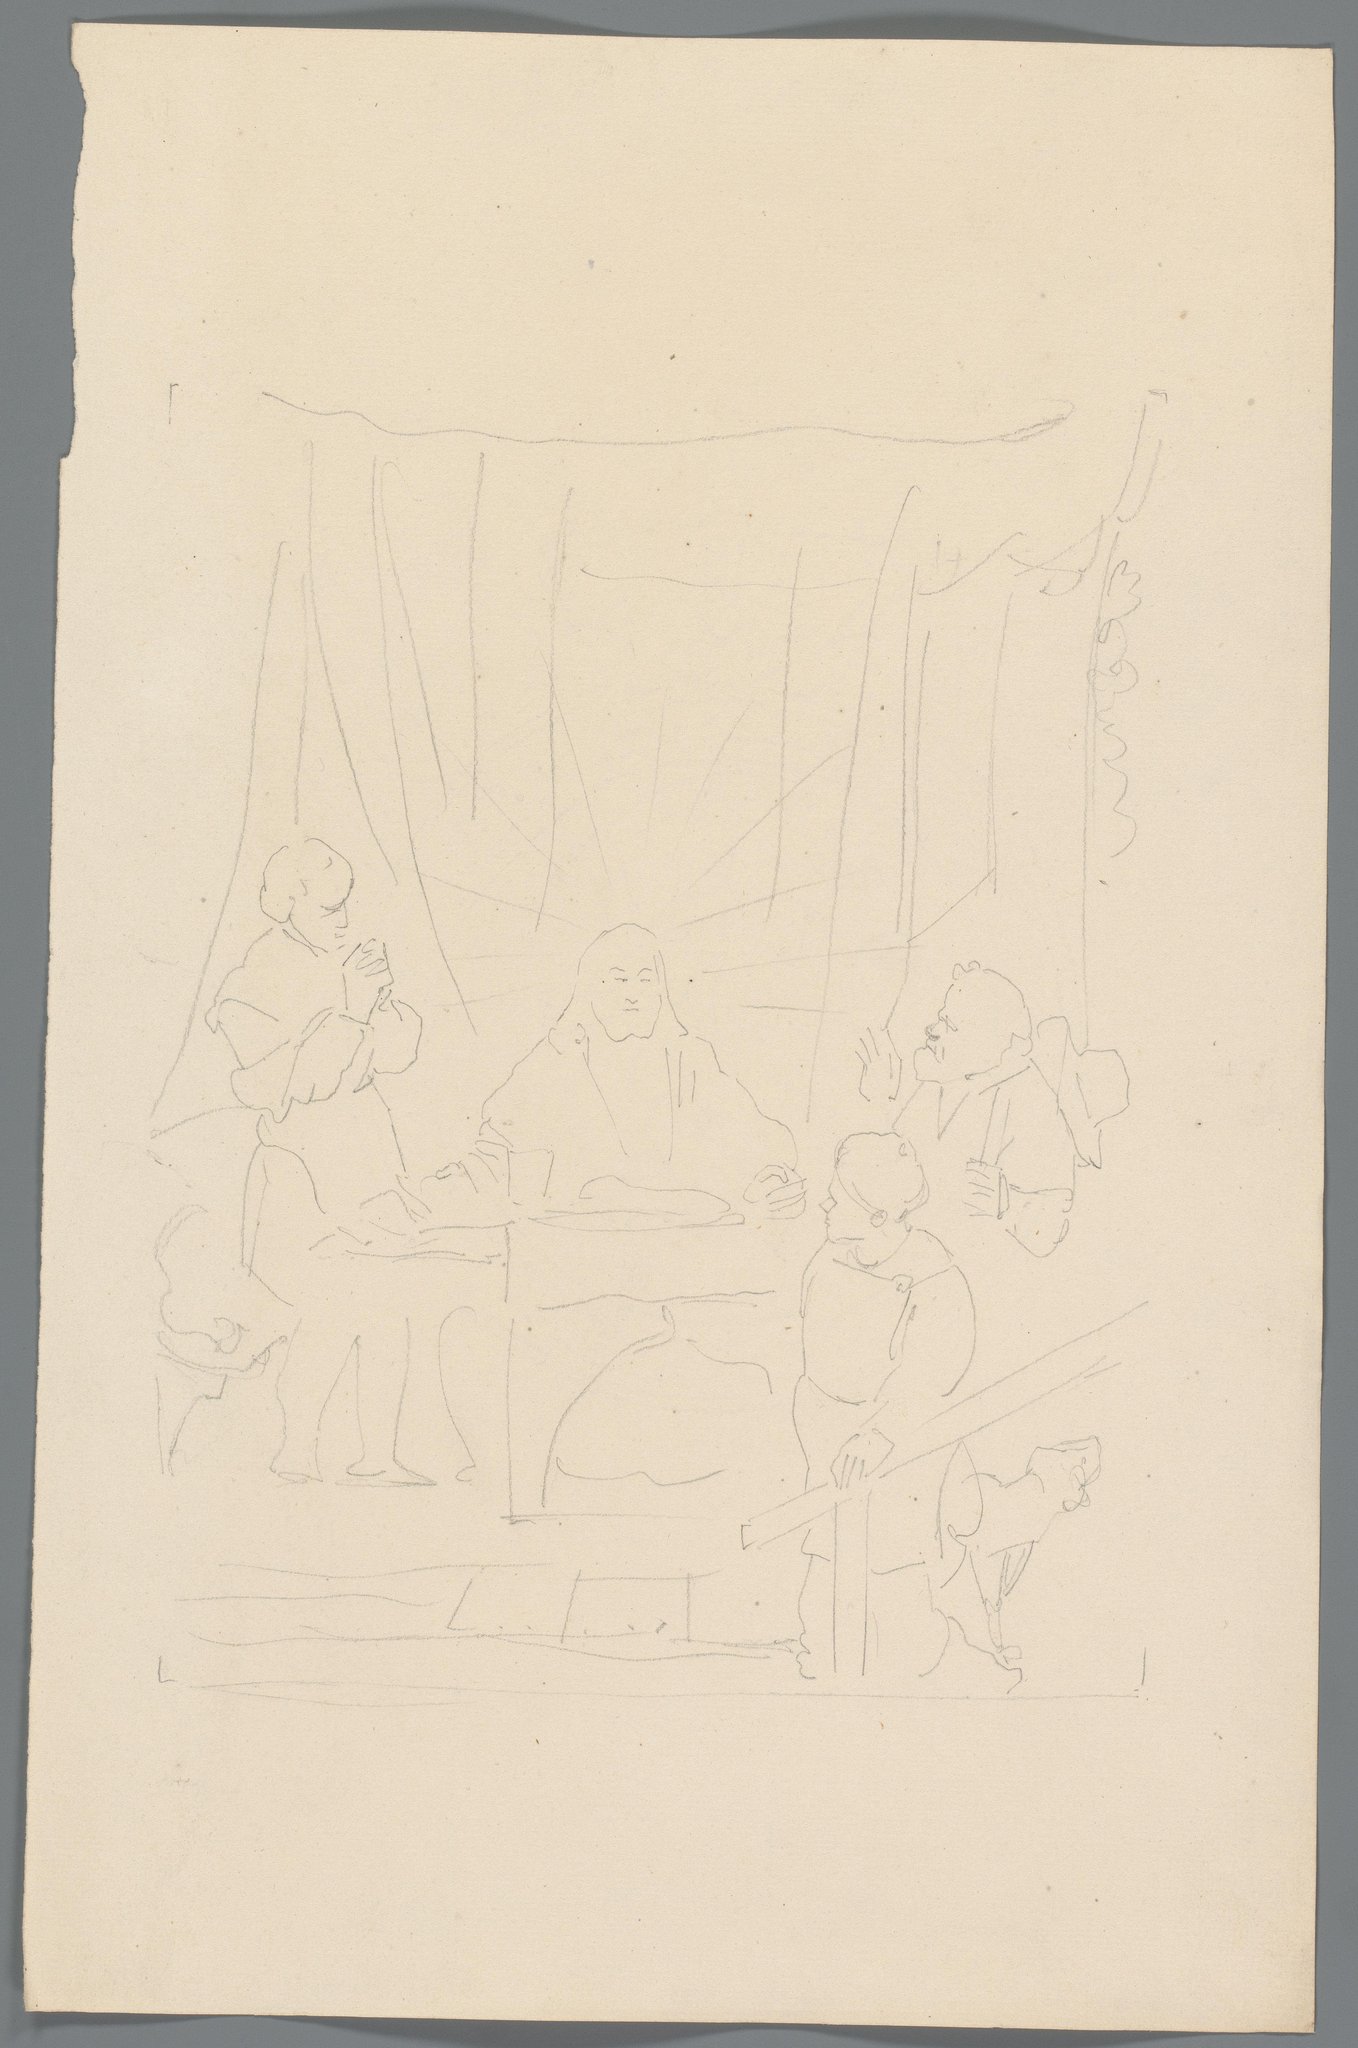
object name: drawing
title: Religieus tafereel met Christus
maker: jacobus everhardus josephus van den berg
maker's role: draughtsman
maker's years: 1802-1861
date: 1812-1861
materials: paper, pencil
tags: public life of christ: from his baptism until the passion